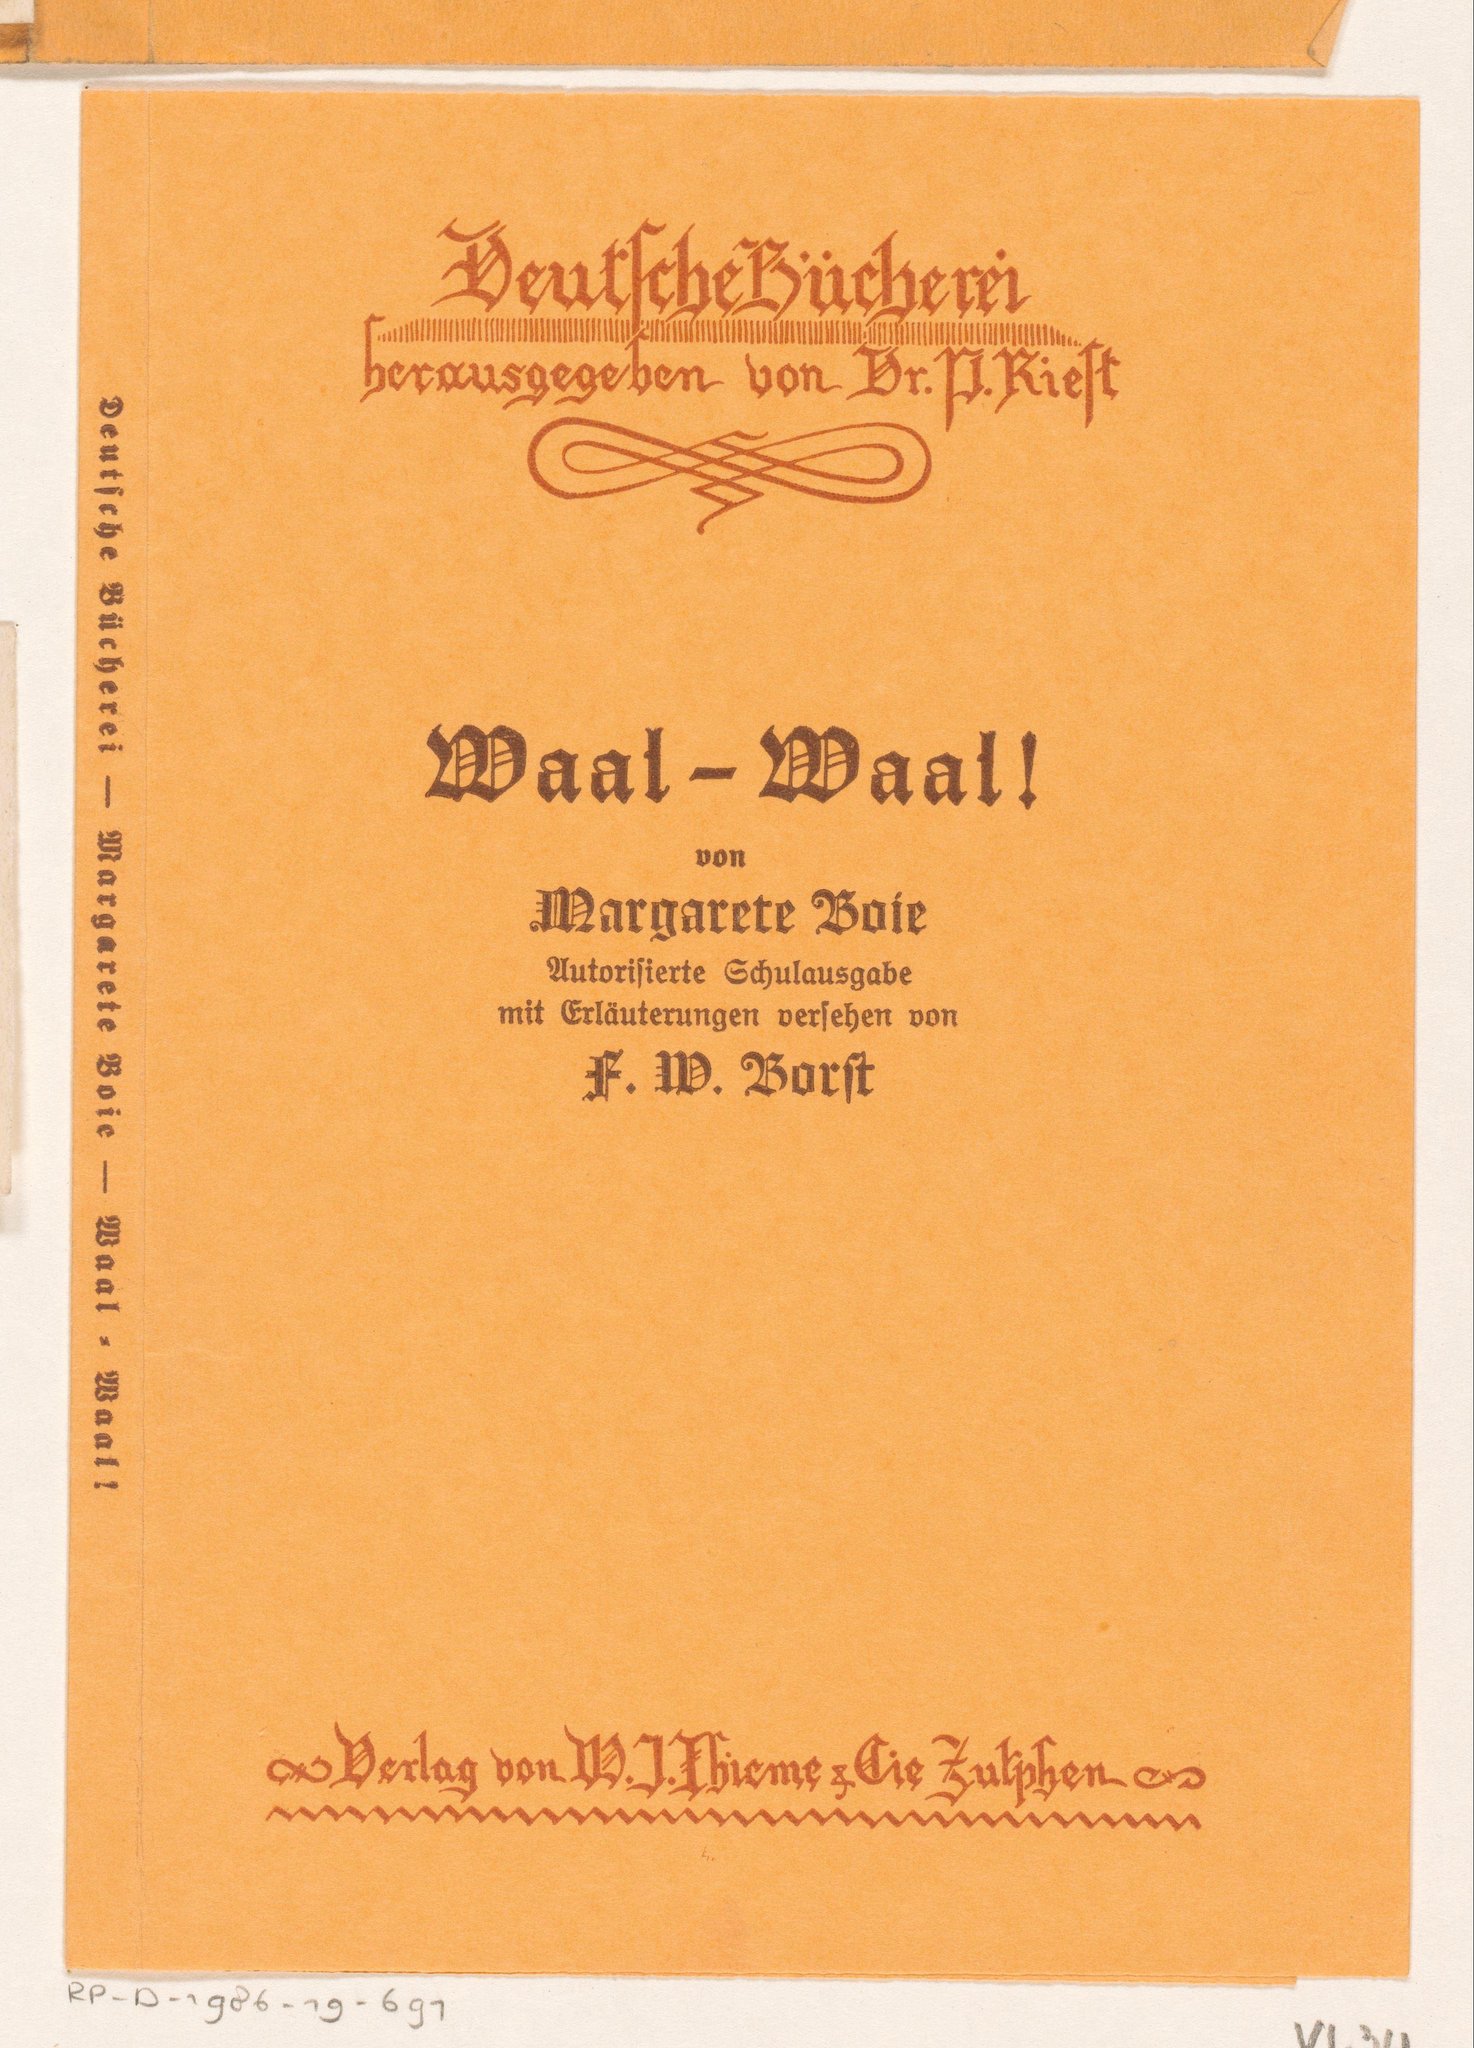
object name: study for binding design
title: Bandontwerp voor: Margarete Boie, Waal - Waal! Das leben eines Sylter Grönlandfährers, 1942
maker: Anonymous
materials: paper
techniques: relief print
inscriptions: collector's mark: ‘R:MVS.’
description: Bandontwerp voor: Boie, Margarete. Waal - Waal! Das leben eines Sylter Grönlandfährers. Zutphen: W.J. Thieme & Cie (schulausgabe mit Erläuteringen versehen von F.W. Borst) 1942.